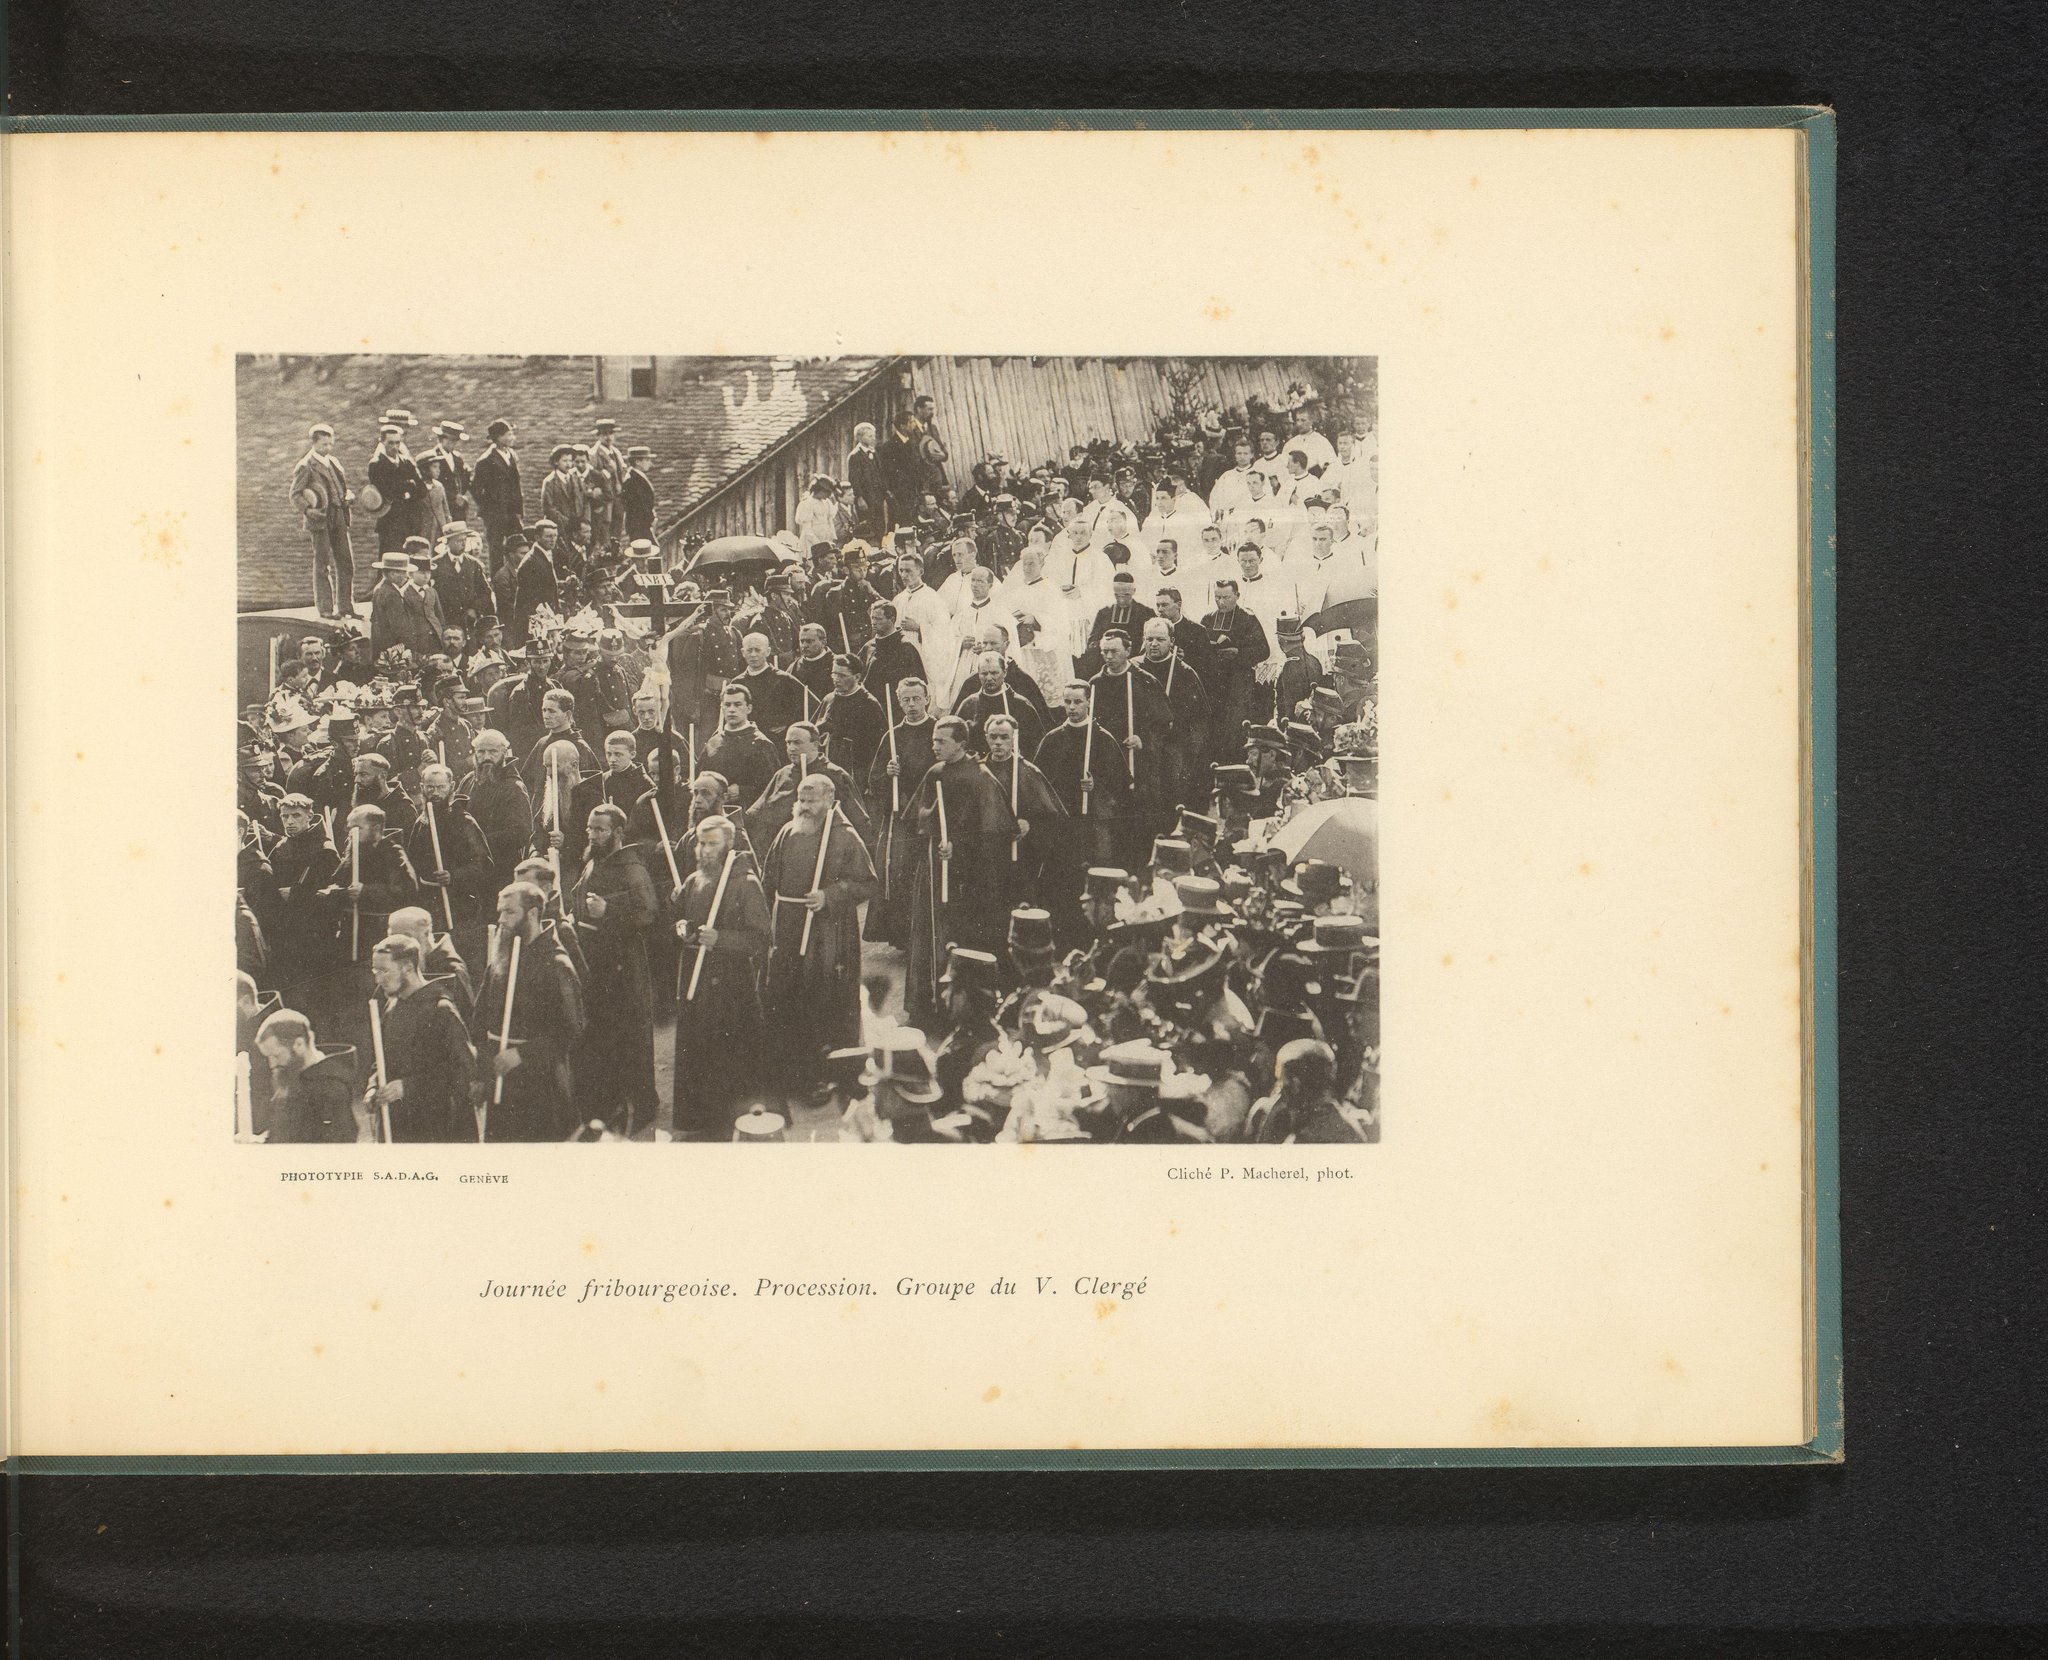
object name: page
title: Processie in Fribourg, vermoedelijk ter herdenking van de sterfdag van Petrus Canisius in 1597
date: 1897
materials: paper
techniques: photograph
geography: fribourg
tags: public festivities, procession ~ christian religion